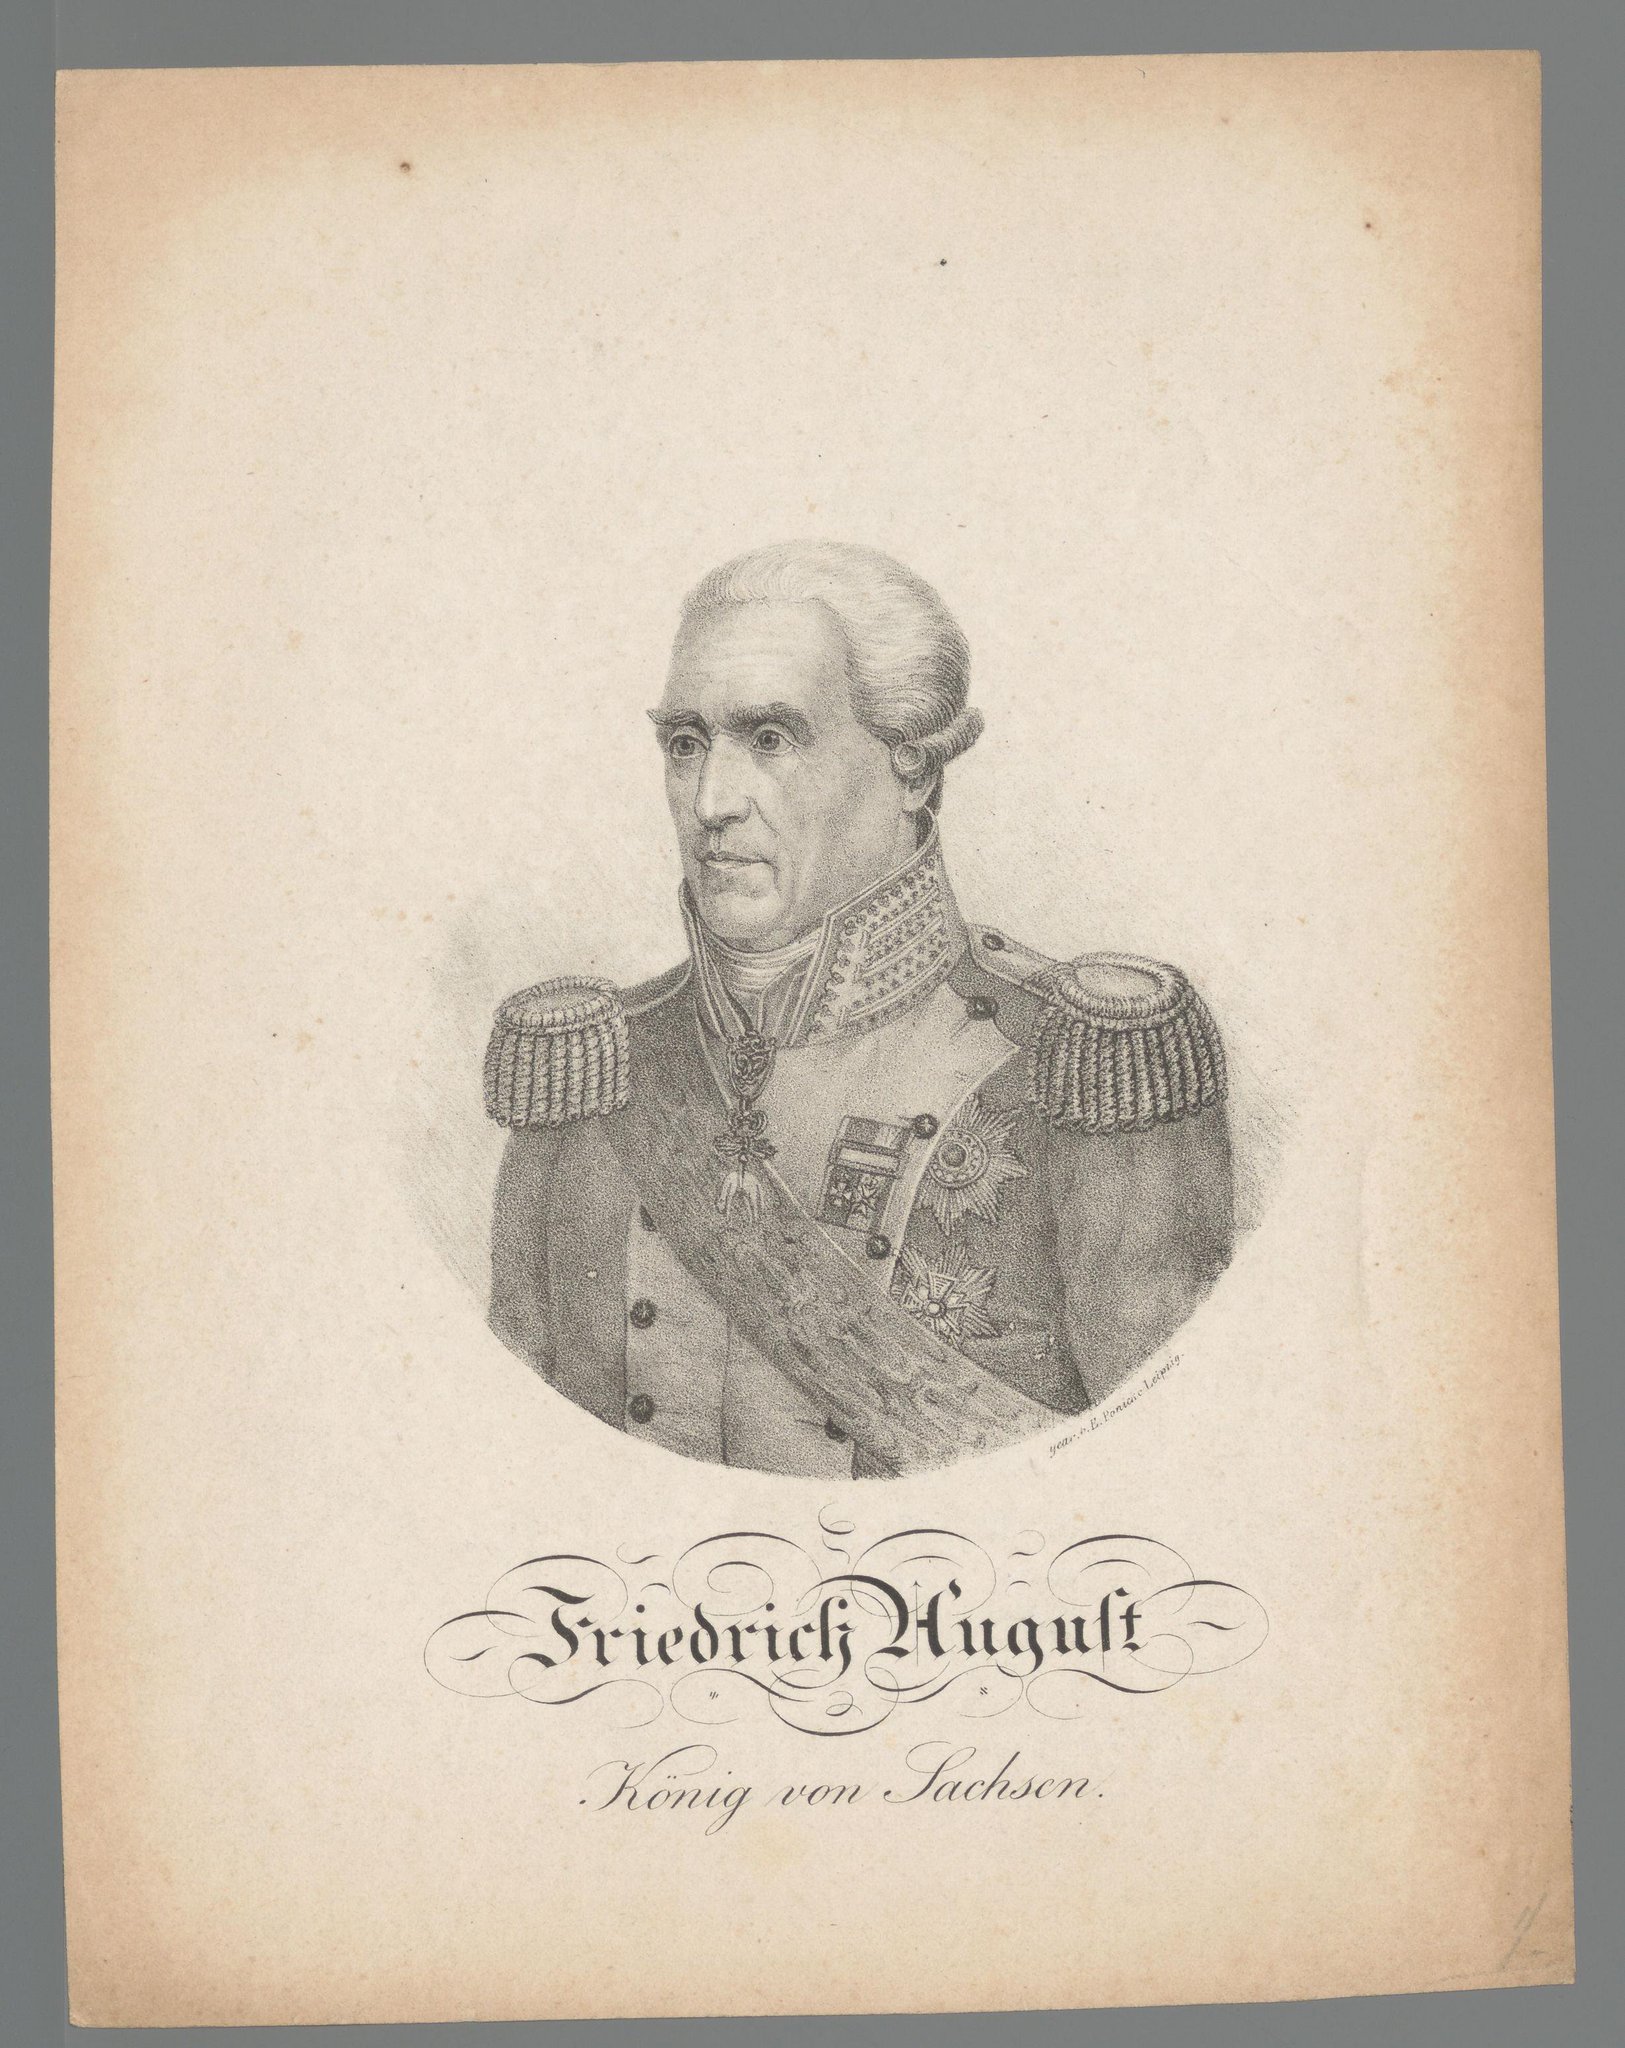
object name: print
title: Portret van Frederik August I, koning van Saksen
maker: Anonymous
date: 1820-1850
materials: paper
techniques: lithograph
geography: leipzig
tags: frederik august i (koning van saksen), adult man, historical persons, knighthood order of the golden fleece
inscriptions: collector's mark: Lugt 2228